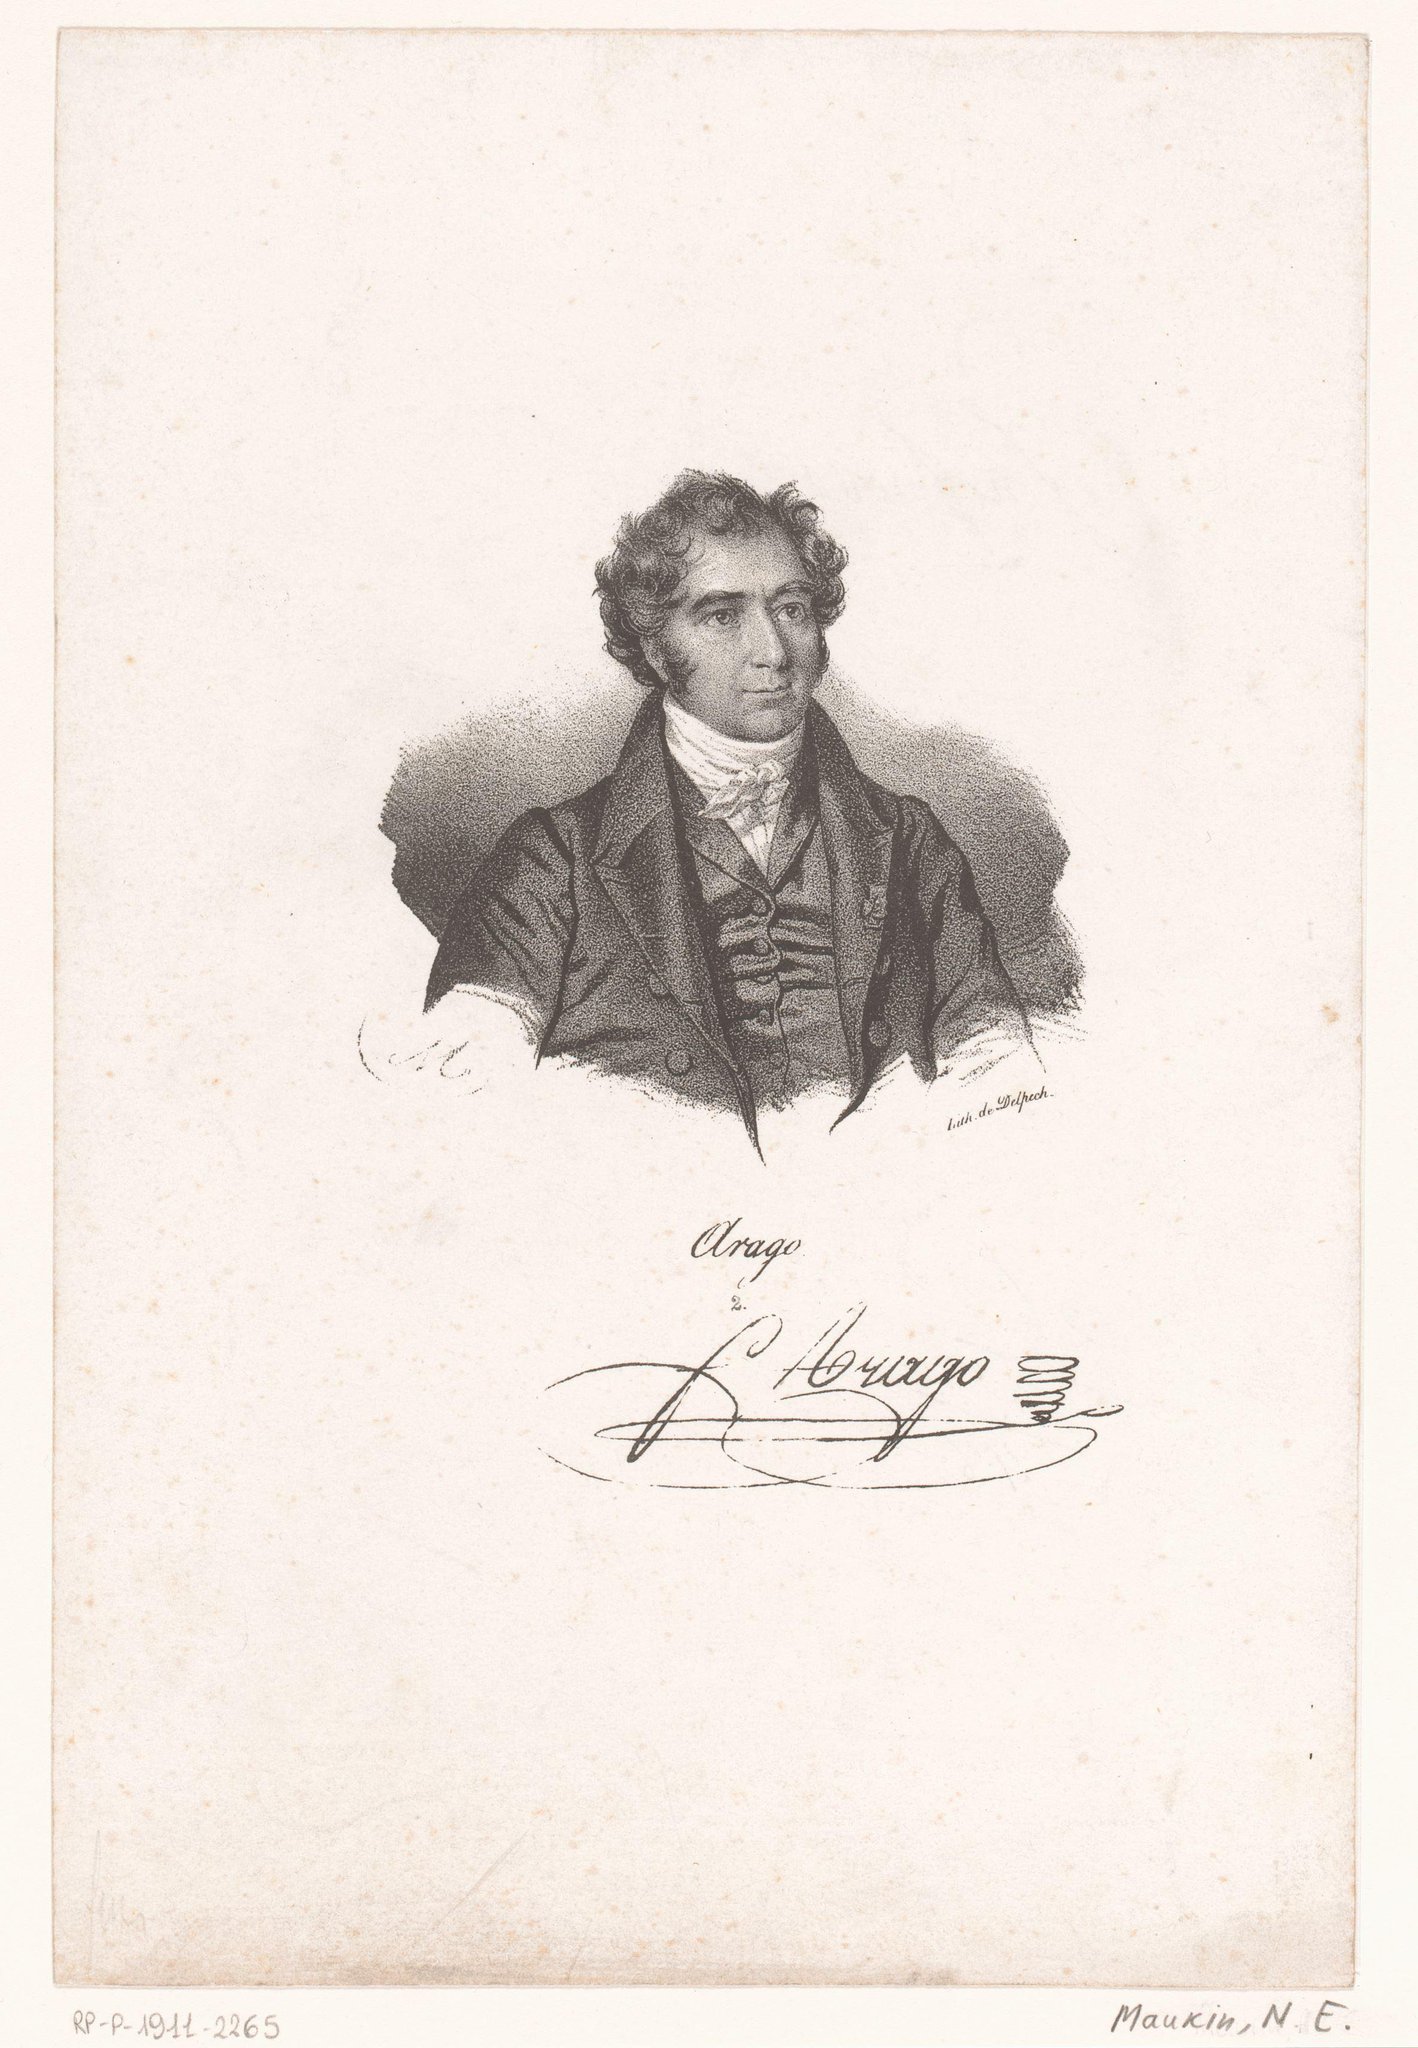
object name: print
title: Portret van François Arago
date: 1825-1842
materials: paper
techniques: lithograph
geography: paris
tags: paris, historical persons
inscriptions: collector's mark: Lugt 2228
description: Prent waarschijnlijk gebruikt voor: Célébrités contemporaines ou portraits des personnes de notre époque (…). Parijs: veuve Delpech, 1842. En/of voor: Célébrités contemporaines ou portraits des personnes de notre époque (…). Parijs: Rosselin, 1845-1849. Mogelijk komt de prent ook voor in eerdere en/of latere publicaties uitgegeven door veuve Delpech of haar opvolger Rosselin.